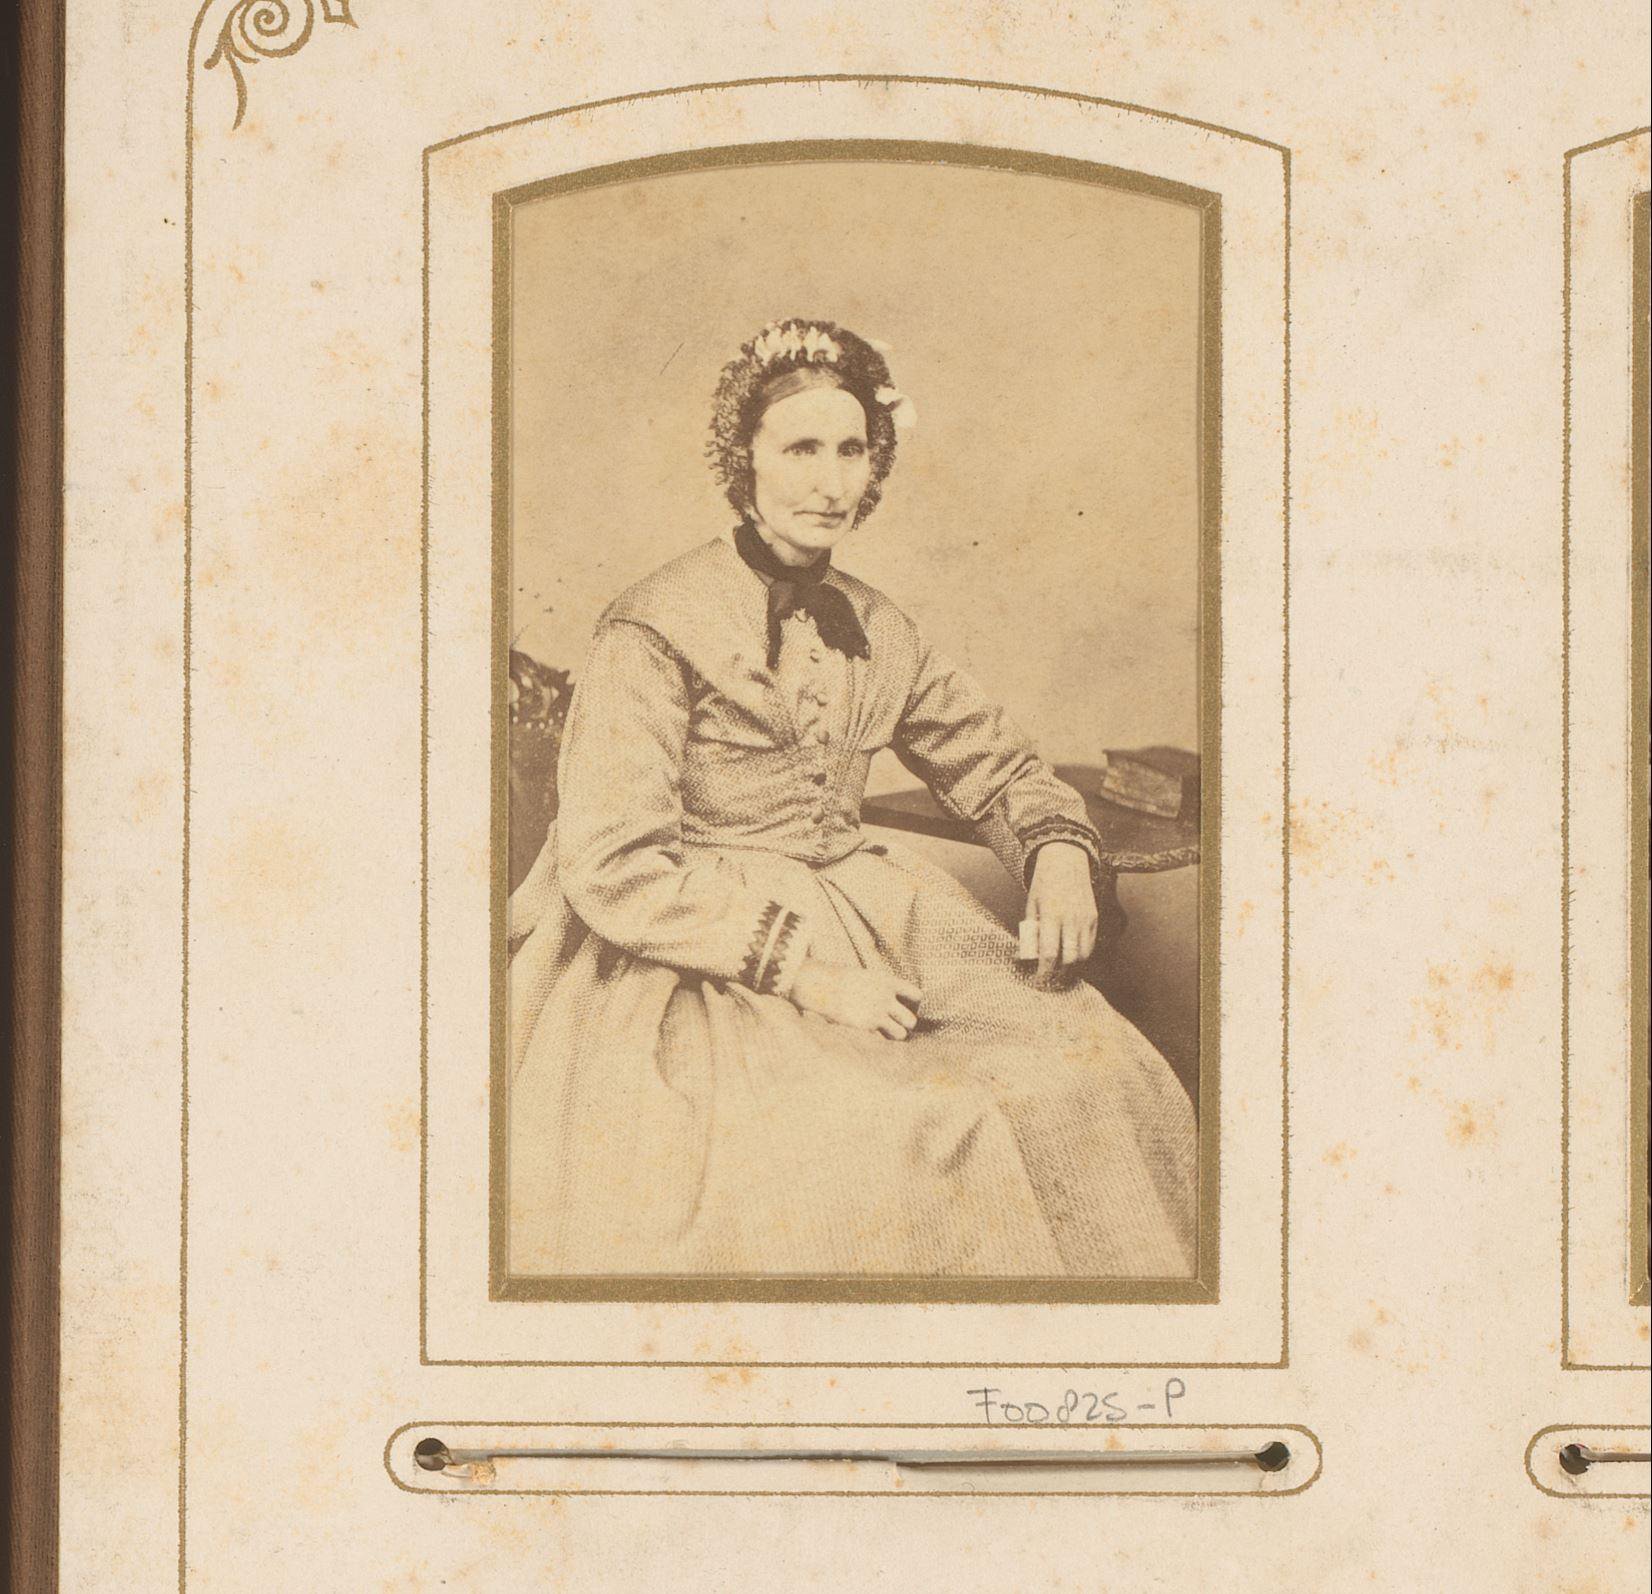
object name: carte de visite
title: Portret van een vrouw met muts, zittend aan een tafel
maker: willem tinker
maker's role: fotograaf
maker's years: 1816-1894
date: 1860-1885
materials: cardboard, photographic support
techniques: albumen print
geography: haarlem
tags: sitting figure - aa - female human figure, historical persons - bb - woman, table, head-gear: cap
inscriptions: inscription: ‘W. TINKER/ Photographe/ HAARLEM.’, annotation: ‘Visis’